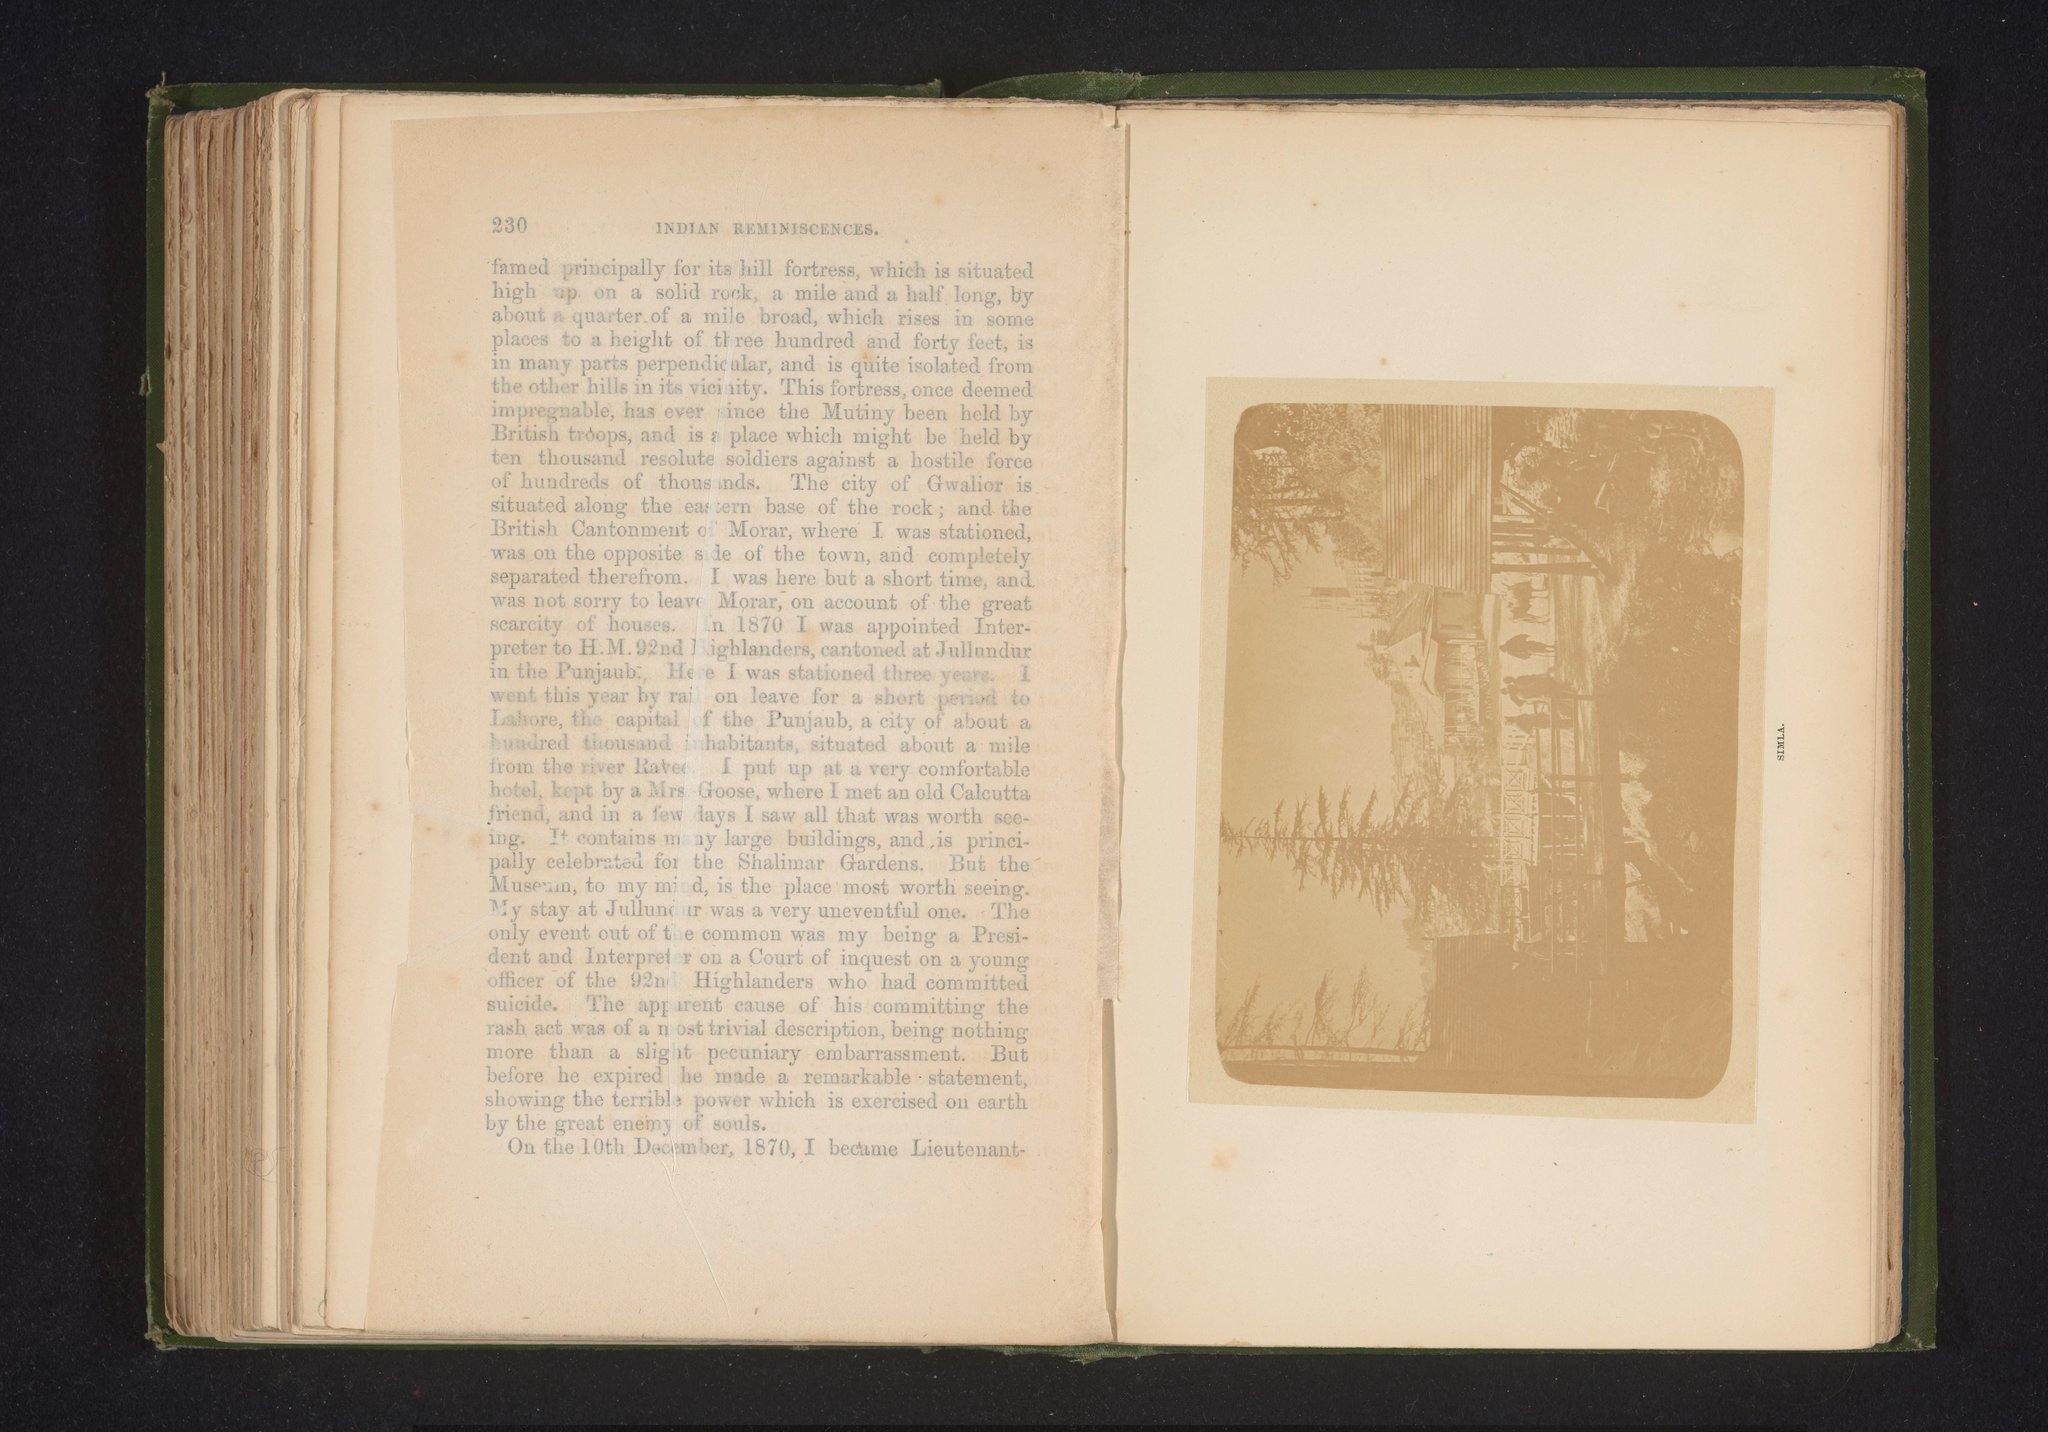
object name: page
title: Simla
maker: Anonymous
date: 1870-1880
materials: photographic support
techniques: albumen print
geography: shimla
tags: city-view in general; 'veduta'